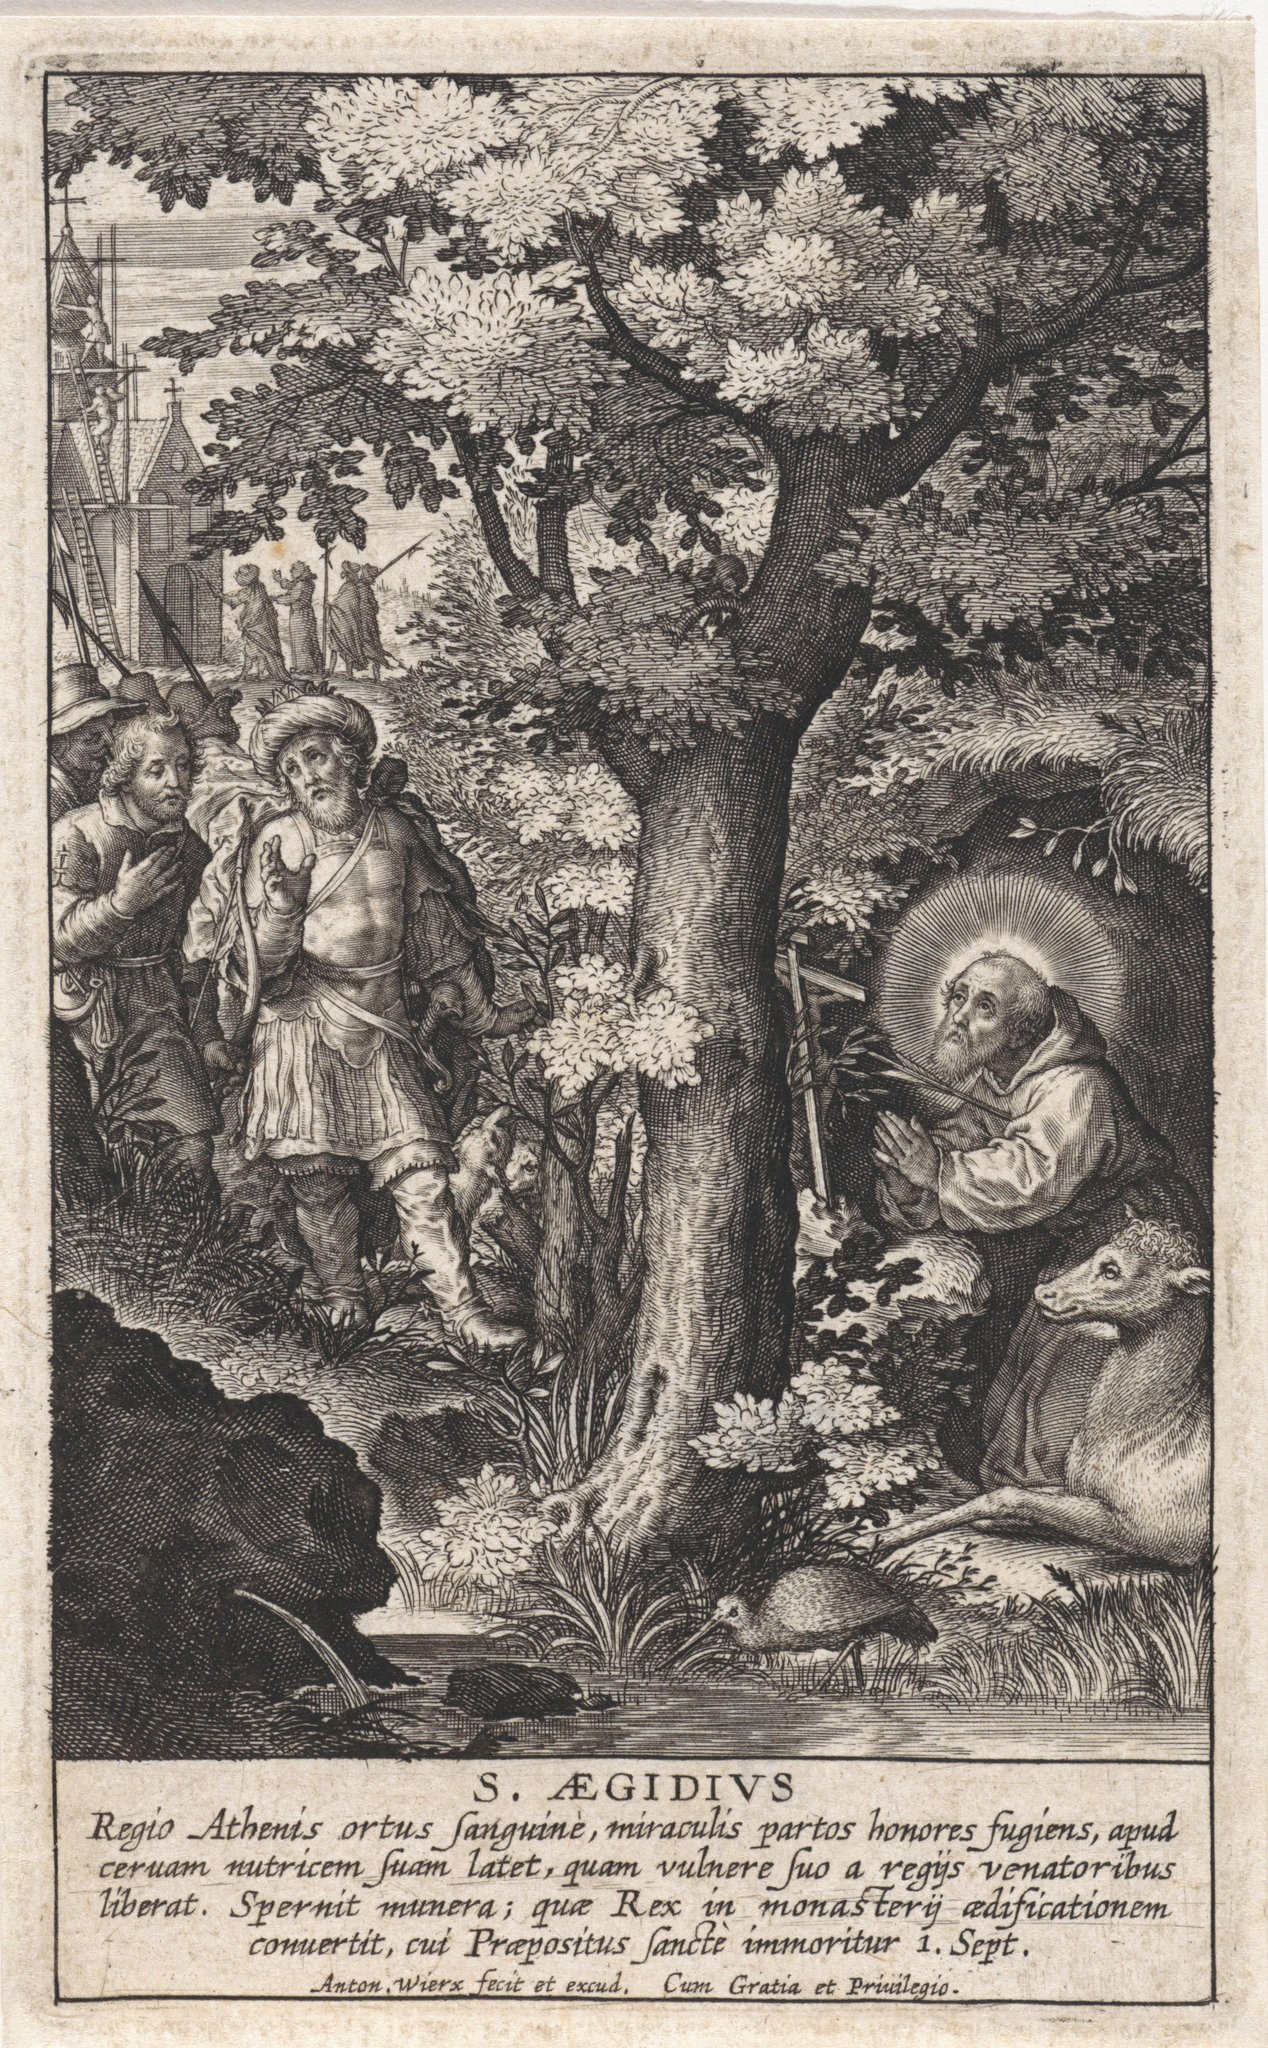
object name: print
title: S. Ægidivs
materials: paper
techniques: engraving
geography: antwerp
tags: the king of the visigoths, out hunting, finds st. giles in his retreat in the woods; giles protects a stag in his arms, and an arrow pierces his hand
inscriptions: collector's mark: Lugt 2228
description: De koning van de Visigoten heeft tijdens de jacht een pijl geschoten naar een hert, maar het lichaam van Aegidius getroffen. De heilige zit onder een boom bij een crucifix, naast het hert waar de koning op mikte. Links op de achtergrond is te zien hoe het benedictijnenklooster van Saint-Gilles gebouwd wordt. In de marge een vierregelig onderschrift in het Latijn.